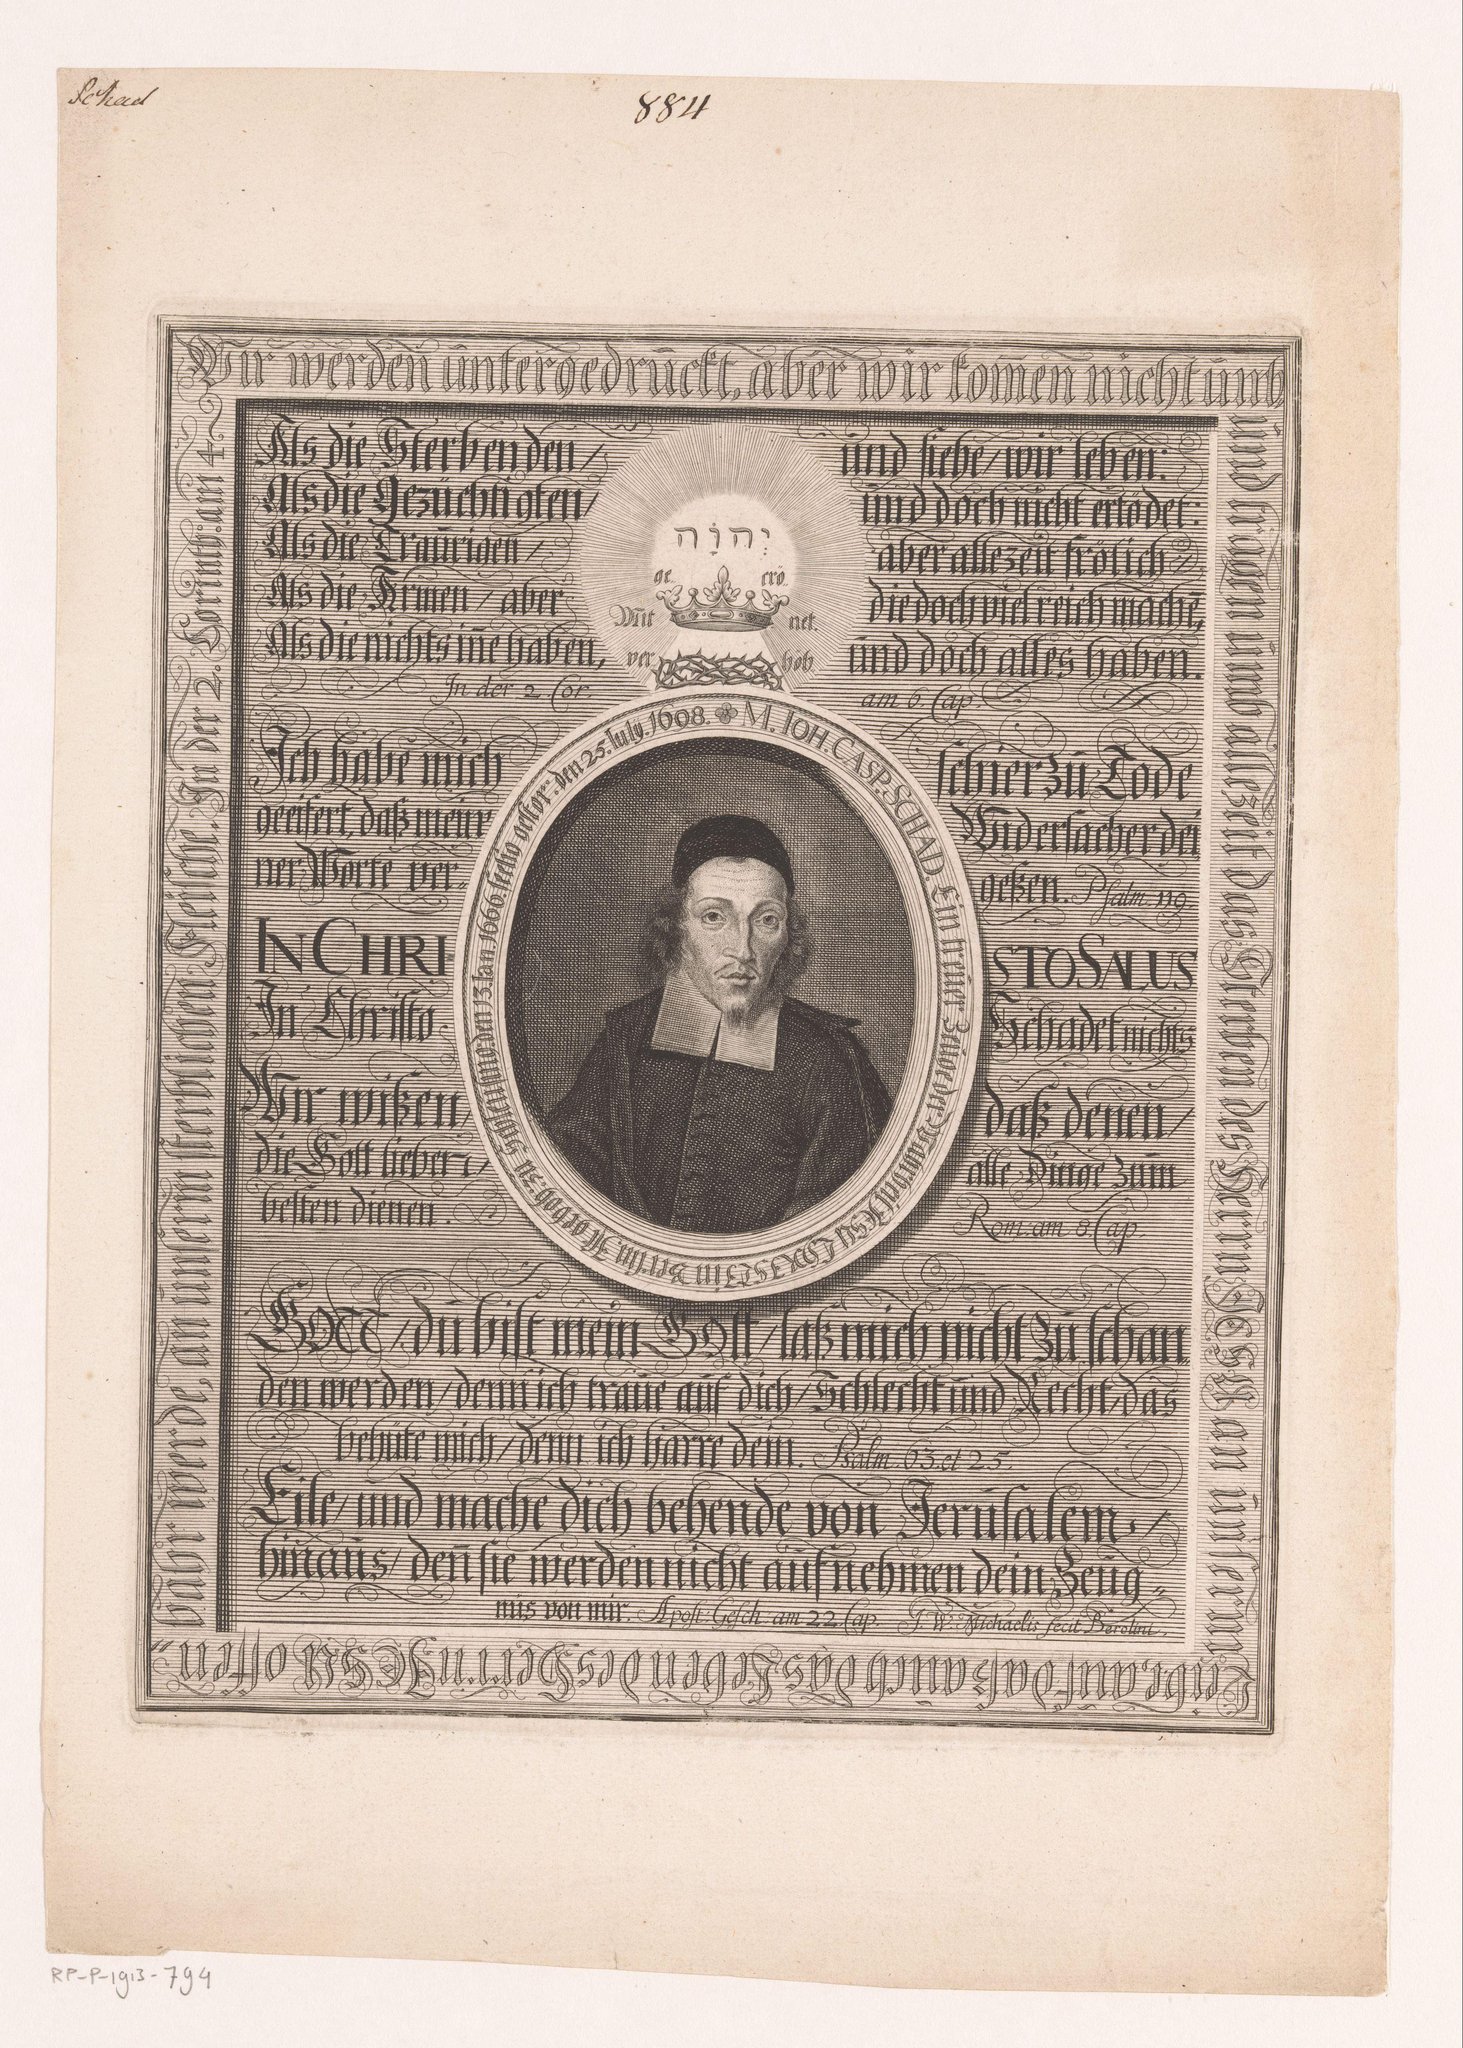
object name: print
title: Portret van Johann Caspar Schade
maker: johann wilhelm michaelis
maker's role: print maker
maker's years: -1737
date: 1698-1737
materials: paper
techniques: engraving, etching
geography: berlin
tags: historical persons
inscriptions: number: ‘884’, collector's mark: Lugt 2228